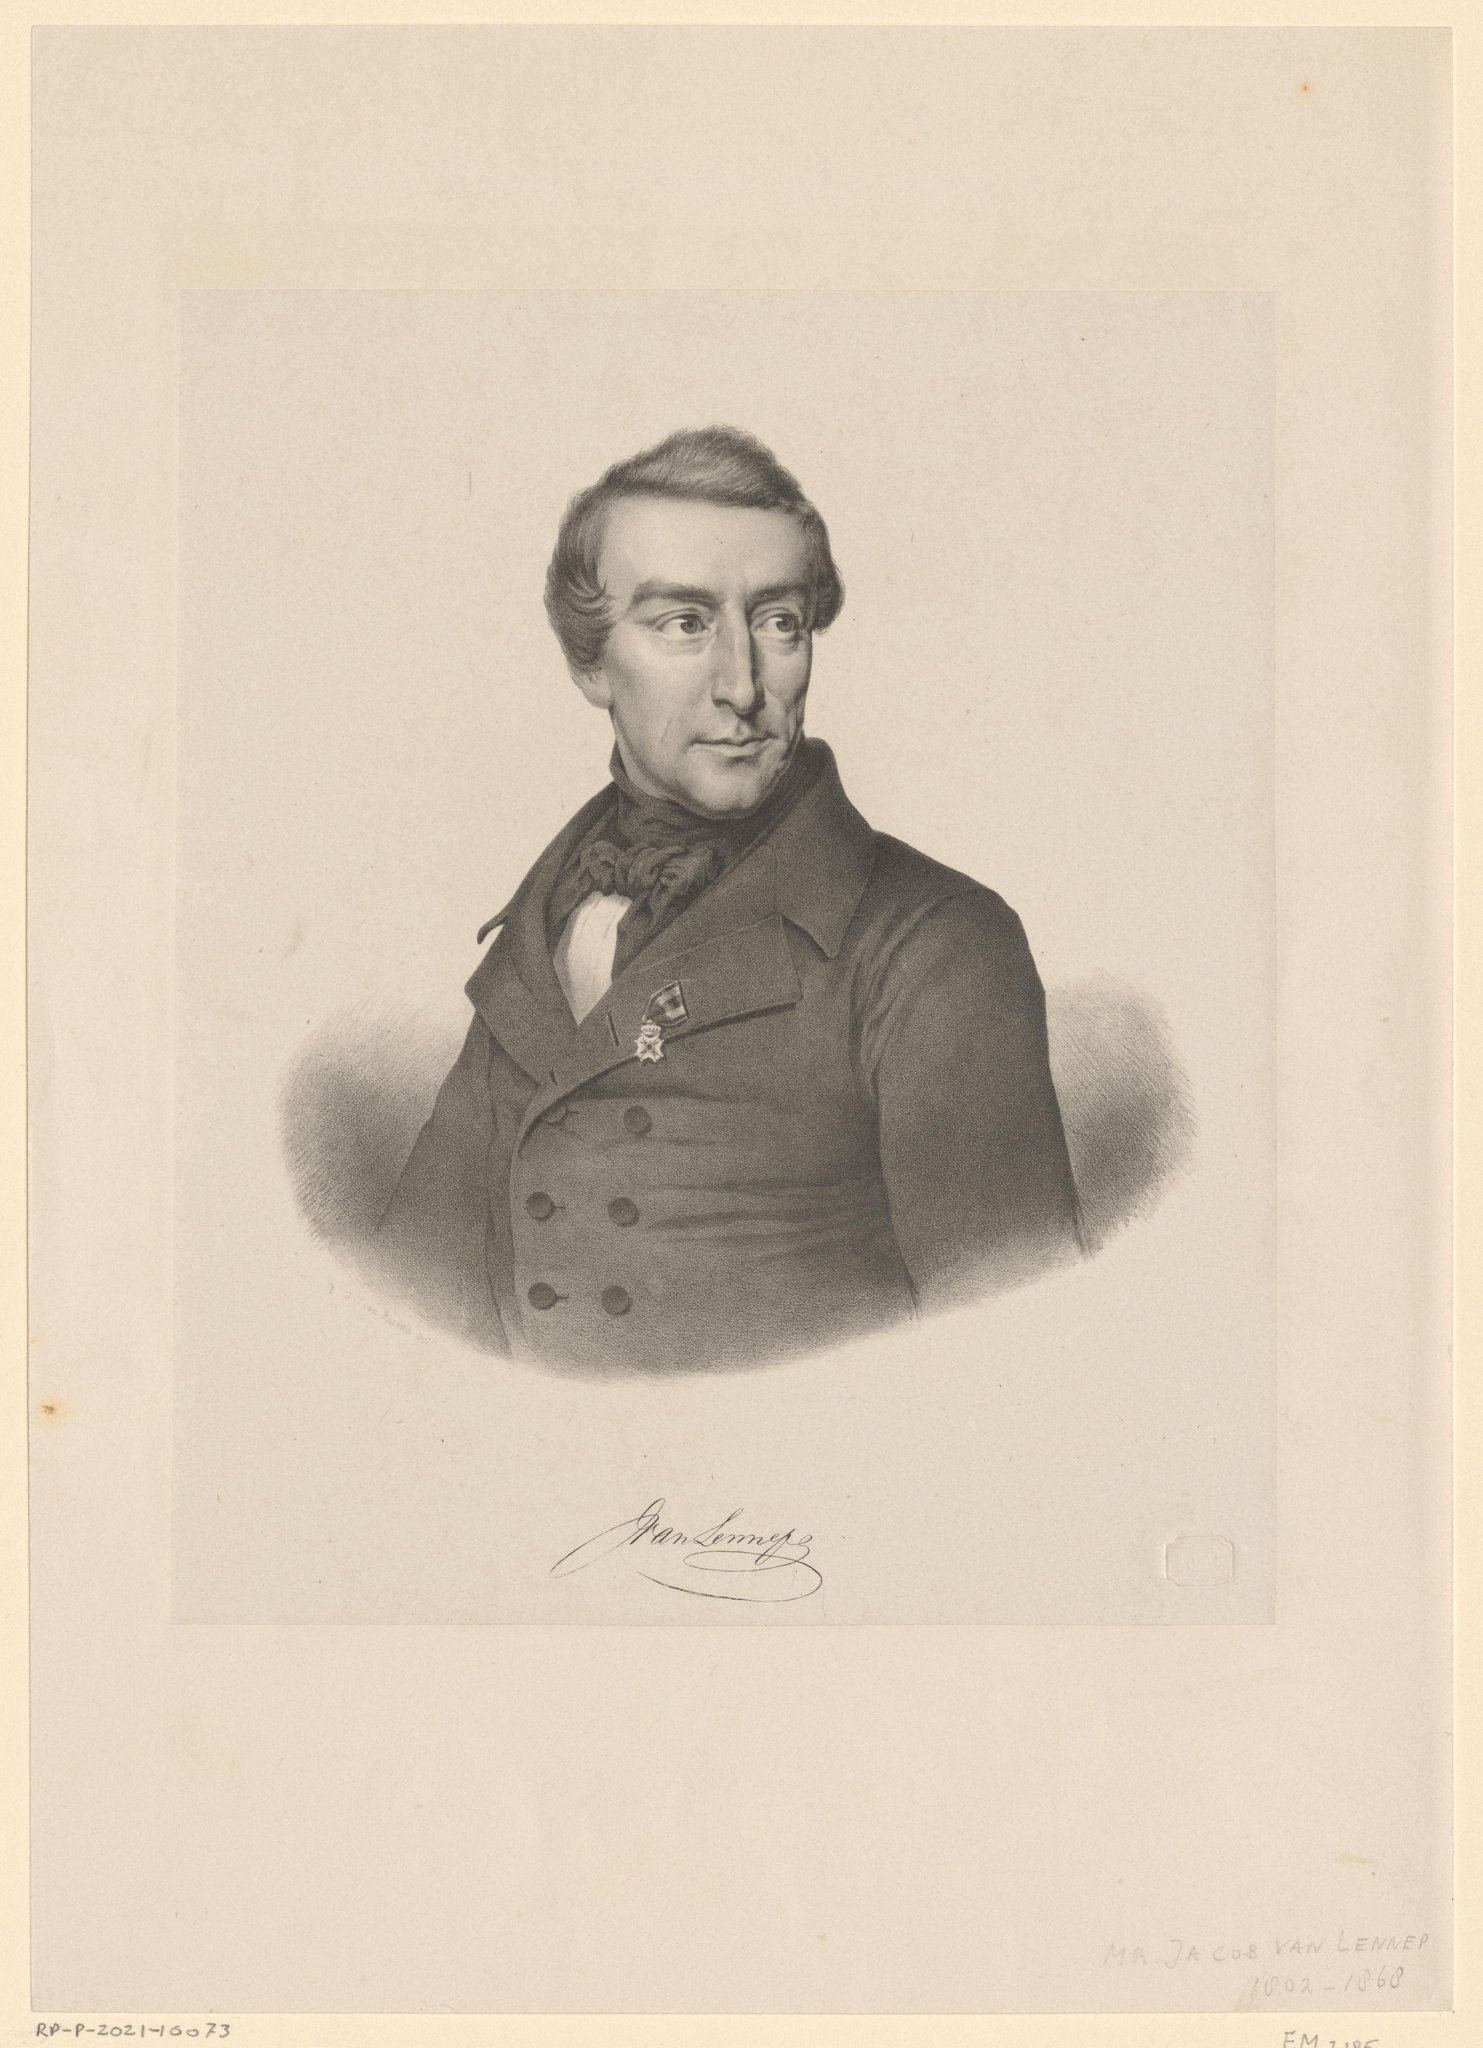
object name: print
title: Portret van Jacob van Lennep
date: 1845-1853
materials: paper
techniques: lithograph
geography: the hague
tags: amsterdam, jacob van lennep, historical persons, portrait of a writer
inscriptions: check stamp: ‘J.C.[v.]R.’, collector's mark: Lugt 2228